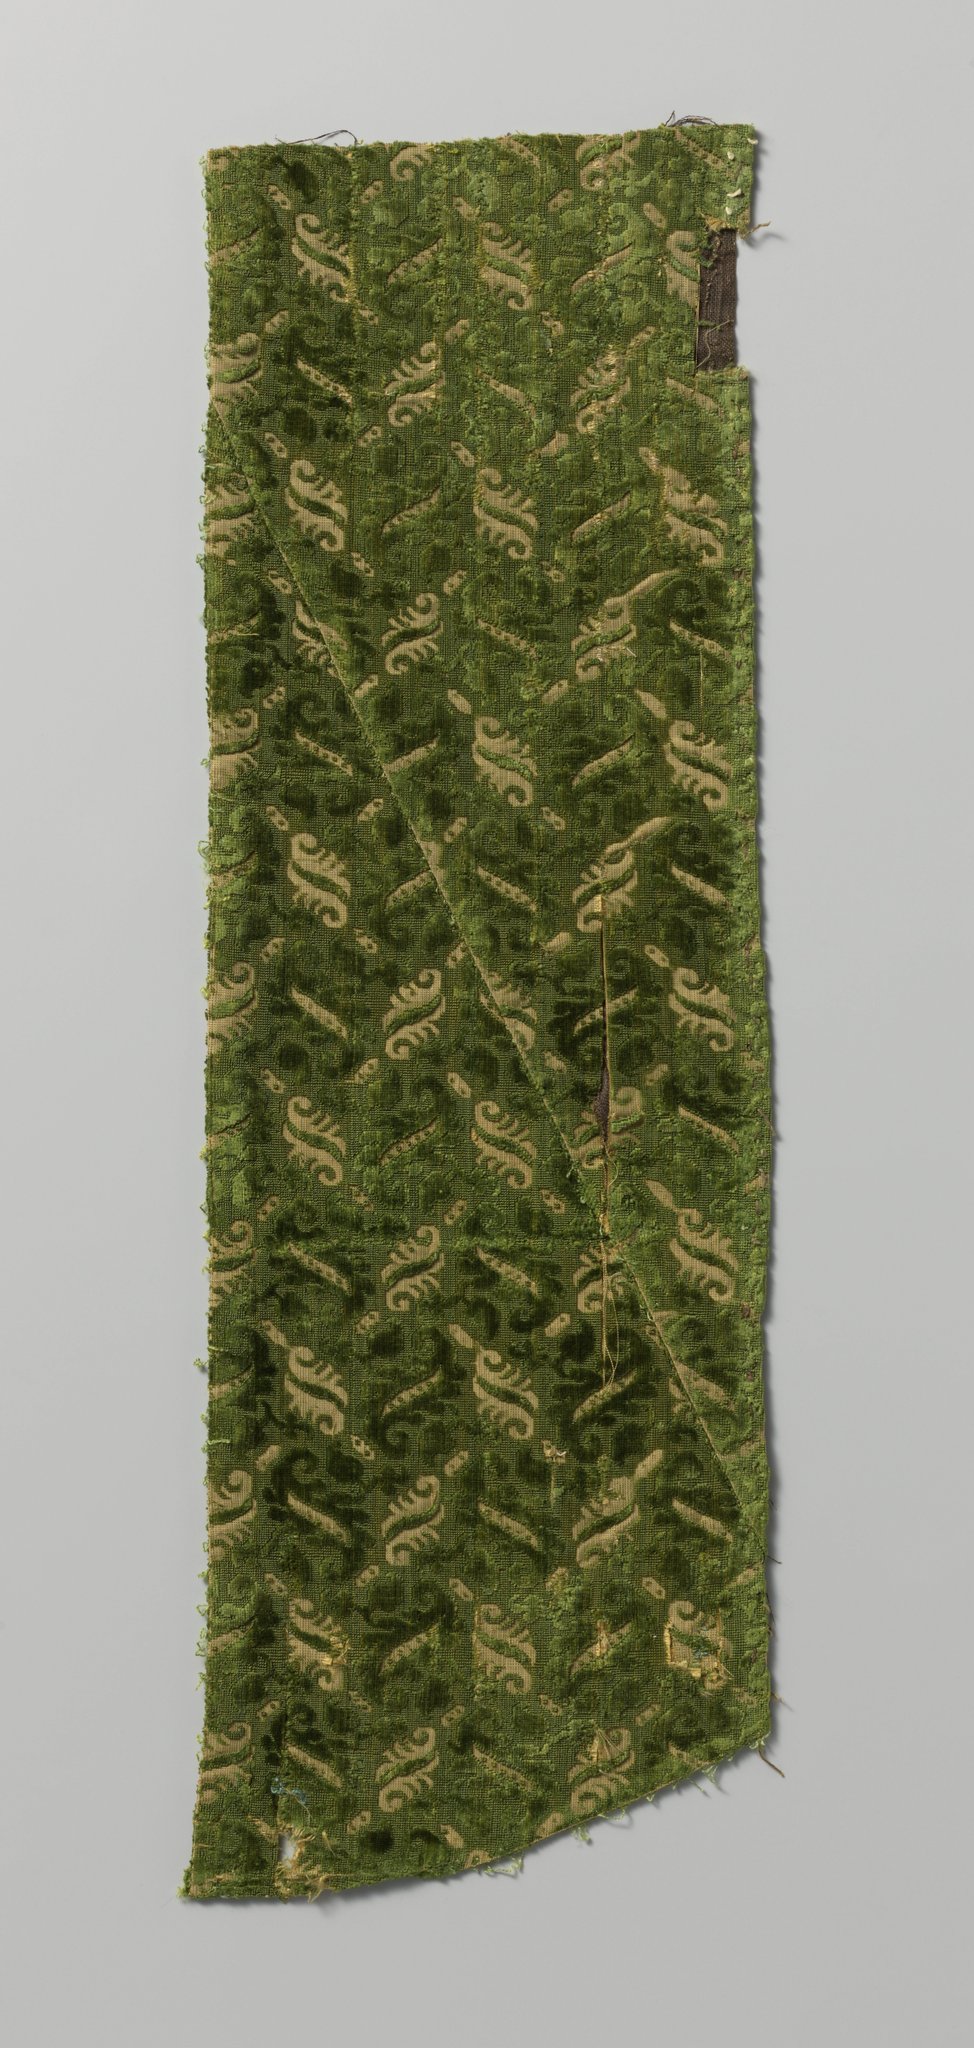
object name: zijdefluweel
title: Fragment zijdefluweel met in geel en groen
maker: Anonymous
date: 1500-1599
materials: silk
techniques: velvet, weave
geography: italy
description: Fragment zijdefluweel met in geel en groen in horizontale rijen dubbele voluten afgewisseld met paragraafachtig motief. Italië, 16de eeuw.